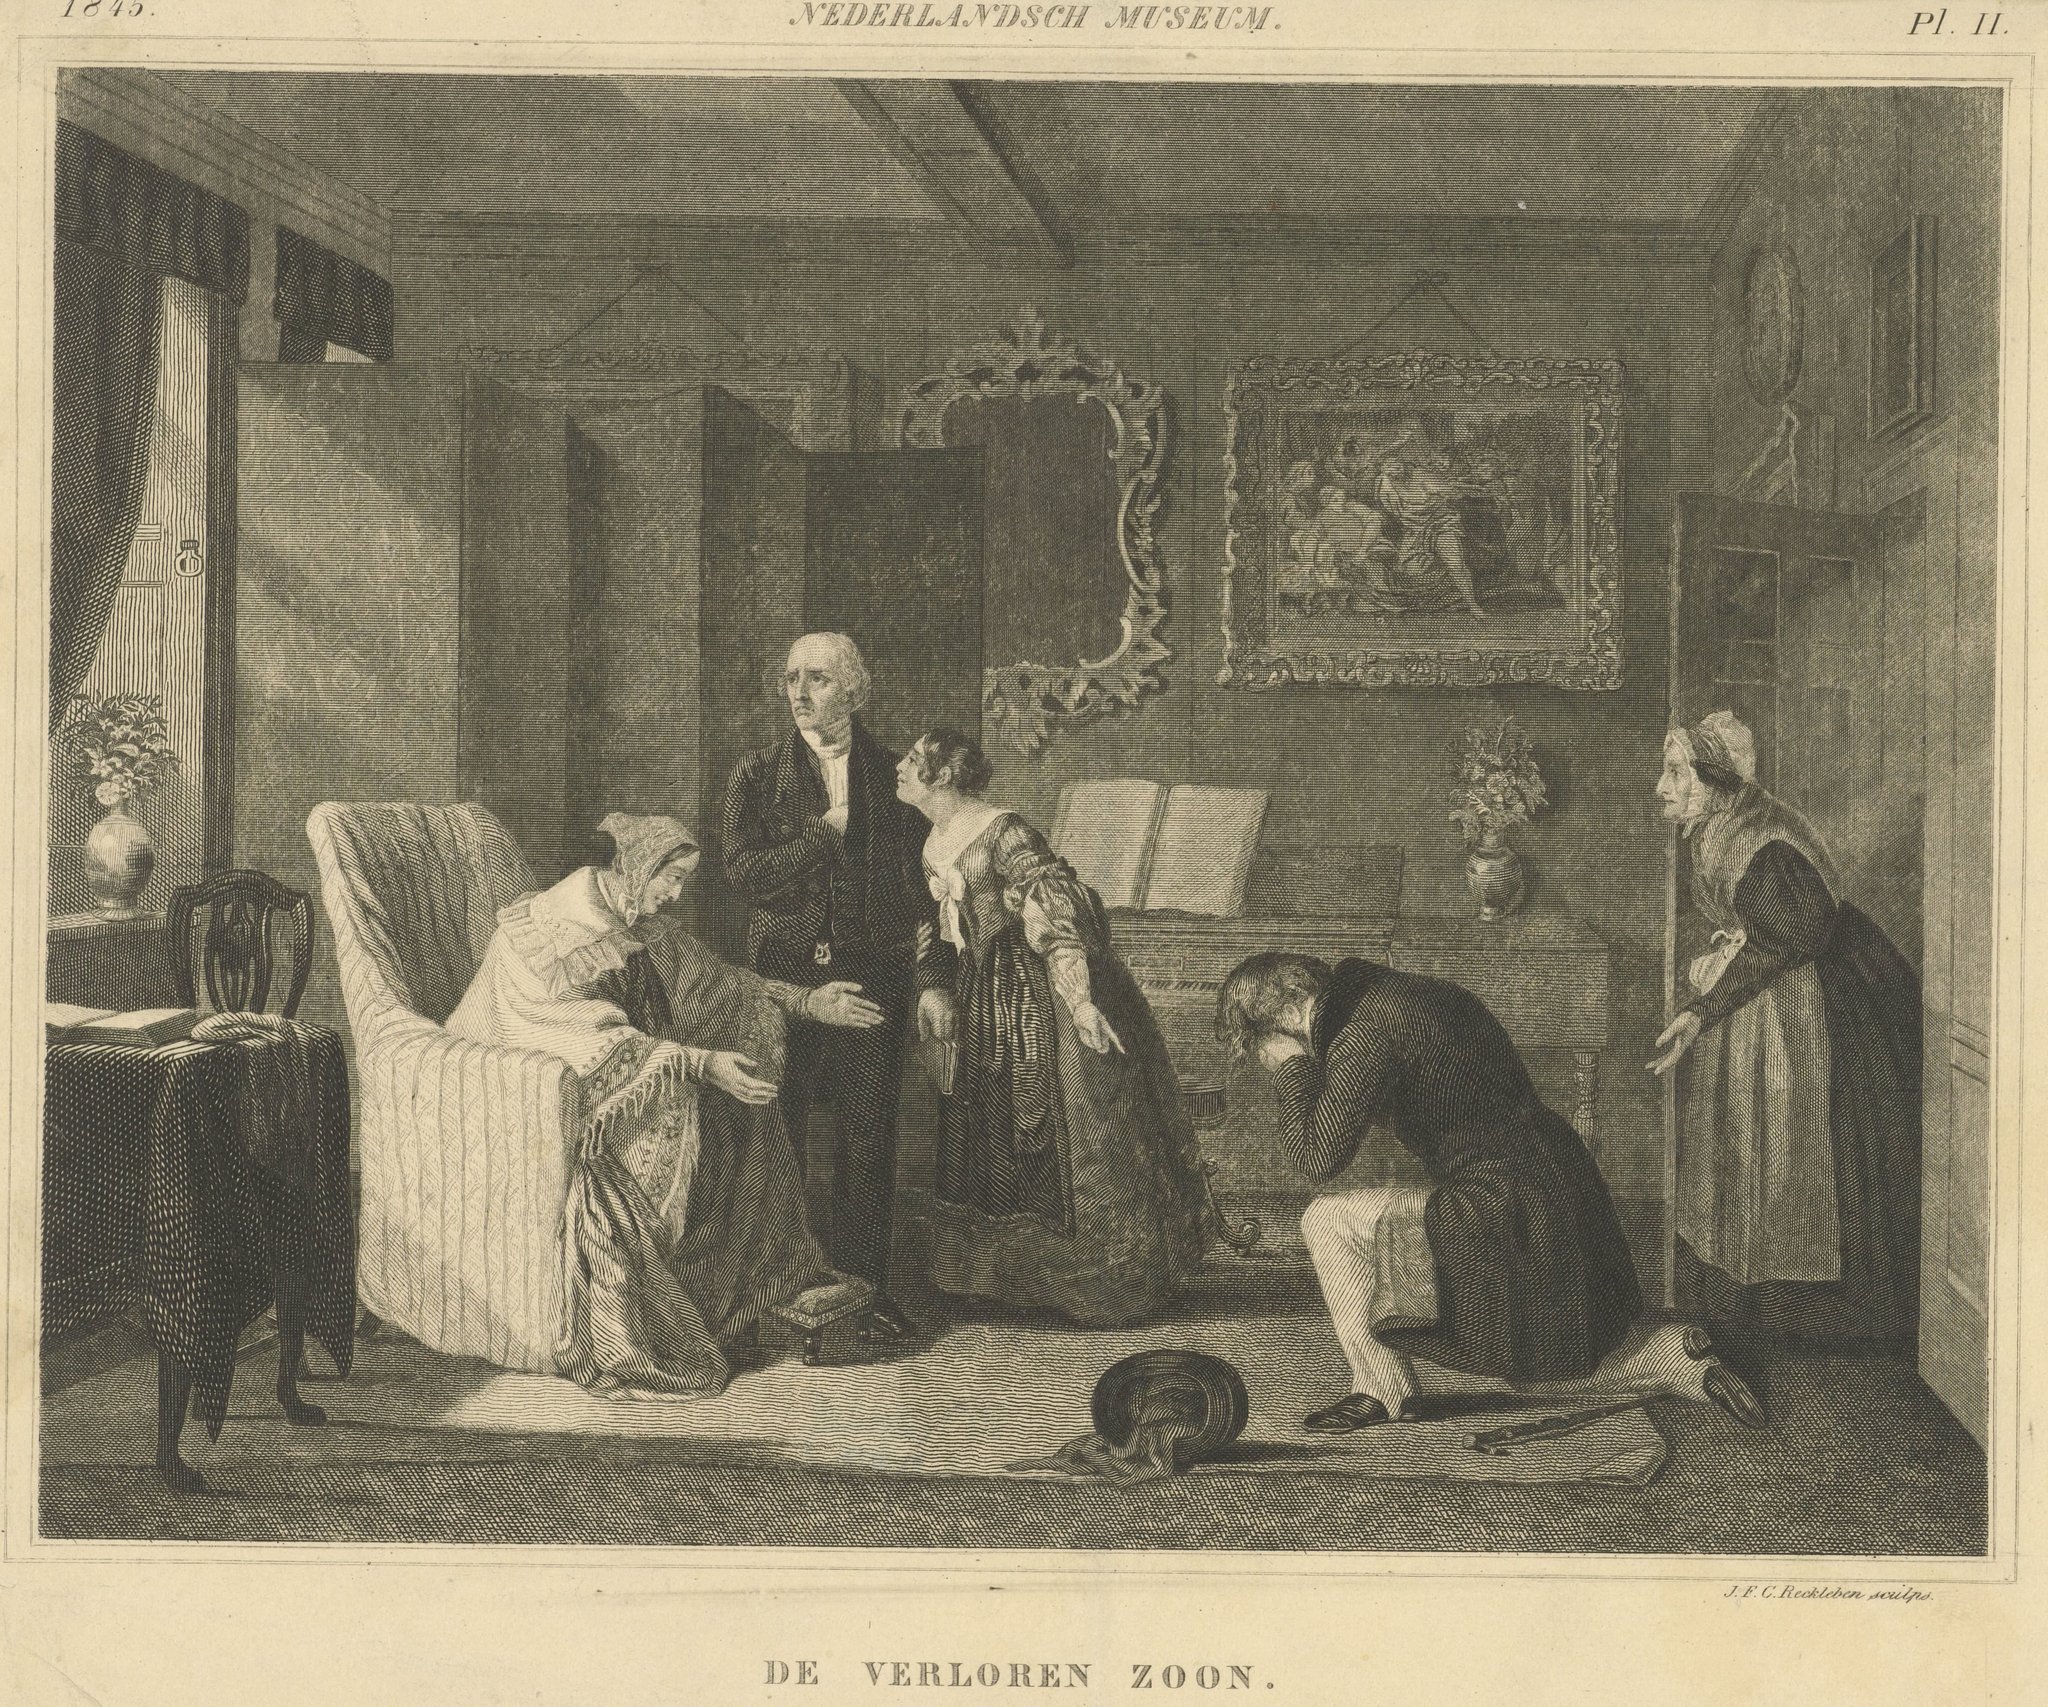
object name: print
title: De verloren zoon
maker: jan frederik christiaan reckleben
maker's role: print maker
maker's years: 1819-1879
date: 1845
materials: paper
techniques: engraving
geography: amsterdam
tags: picture, painting, the parable of the prodigal son (luke 15:11-32)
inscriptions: collector's mark: Lugt 2228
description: In het ouderlijk huis toont de verloren zoon berouw. Hij wordt verwelkomd door zijn moeder, die op een stoel zit. De vader, die naast de moeder staat, houdt de hand op het hart. Aan de muur hangen verschillende schilderijen. De verloren zoon is afgebeeld als 19de-eeuws persoon en de scene speelt zich af in een 19de-eeuw interieur.